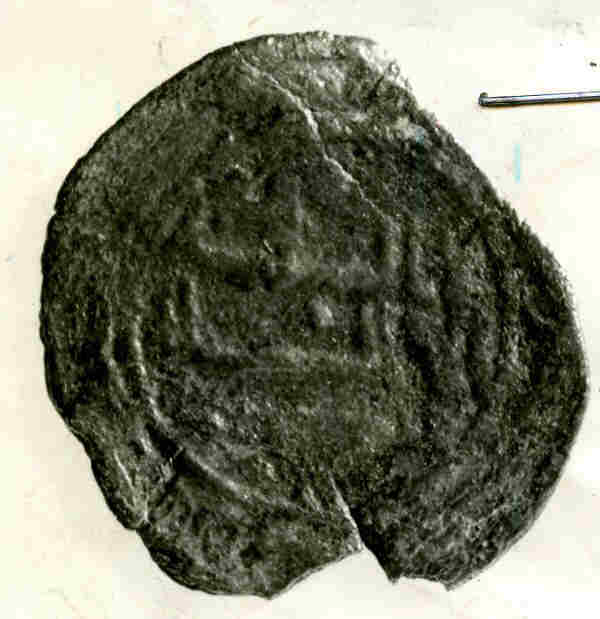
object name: coin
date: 701-800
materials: copper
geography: iran